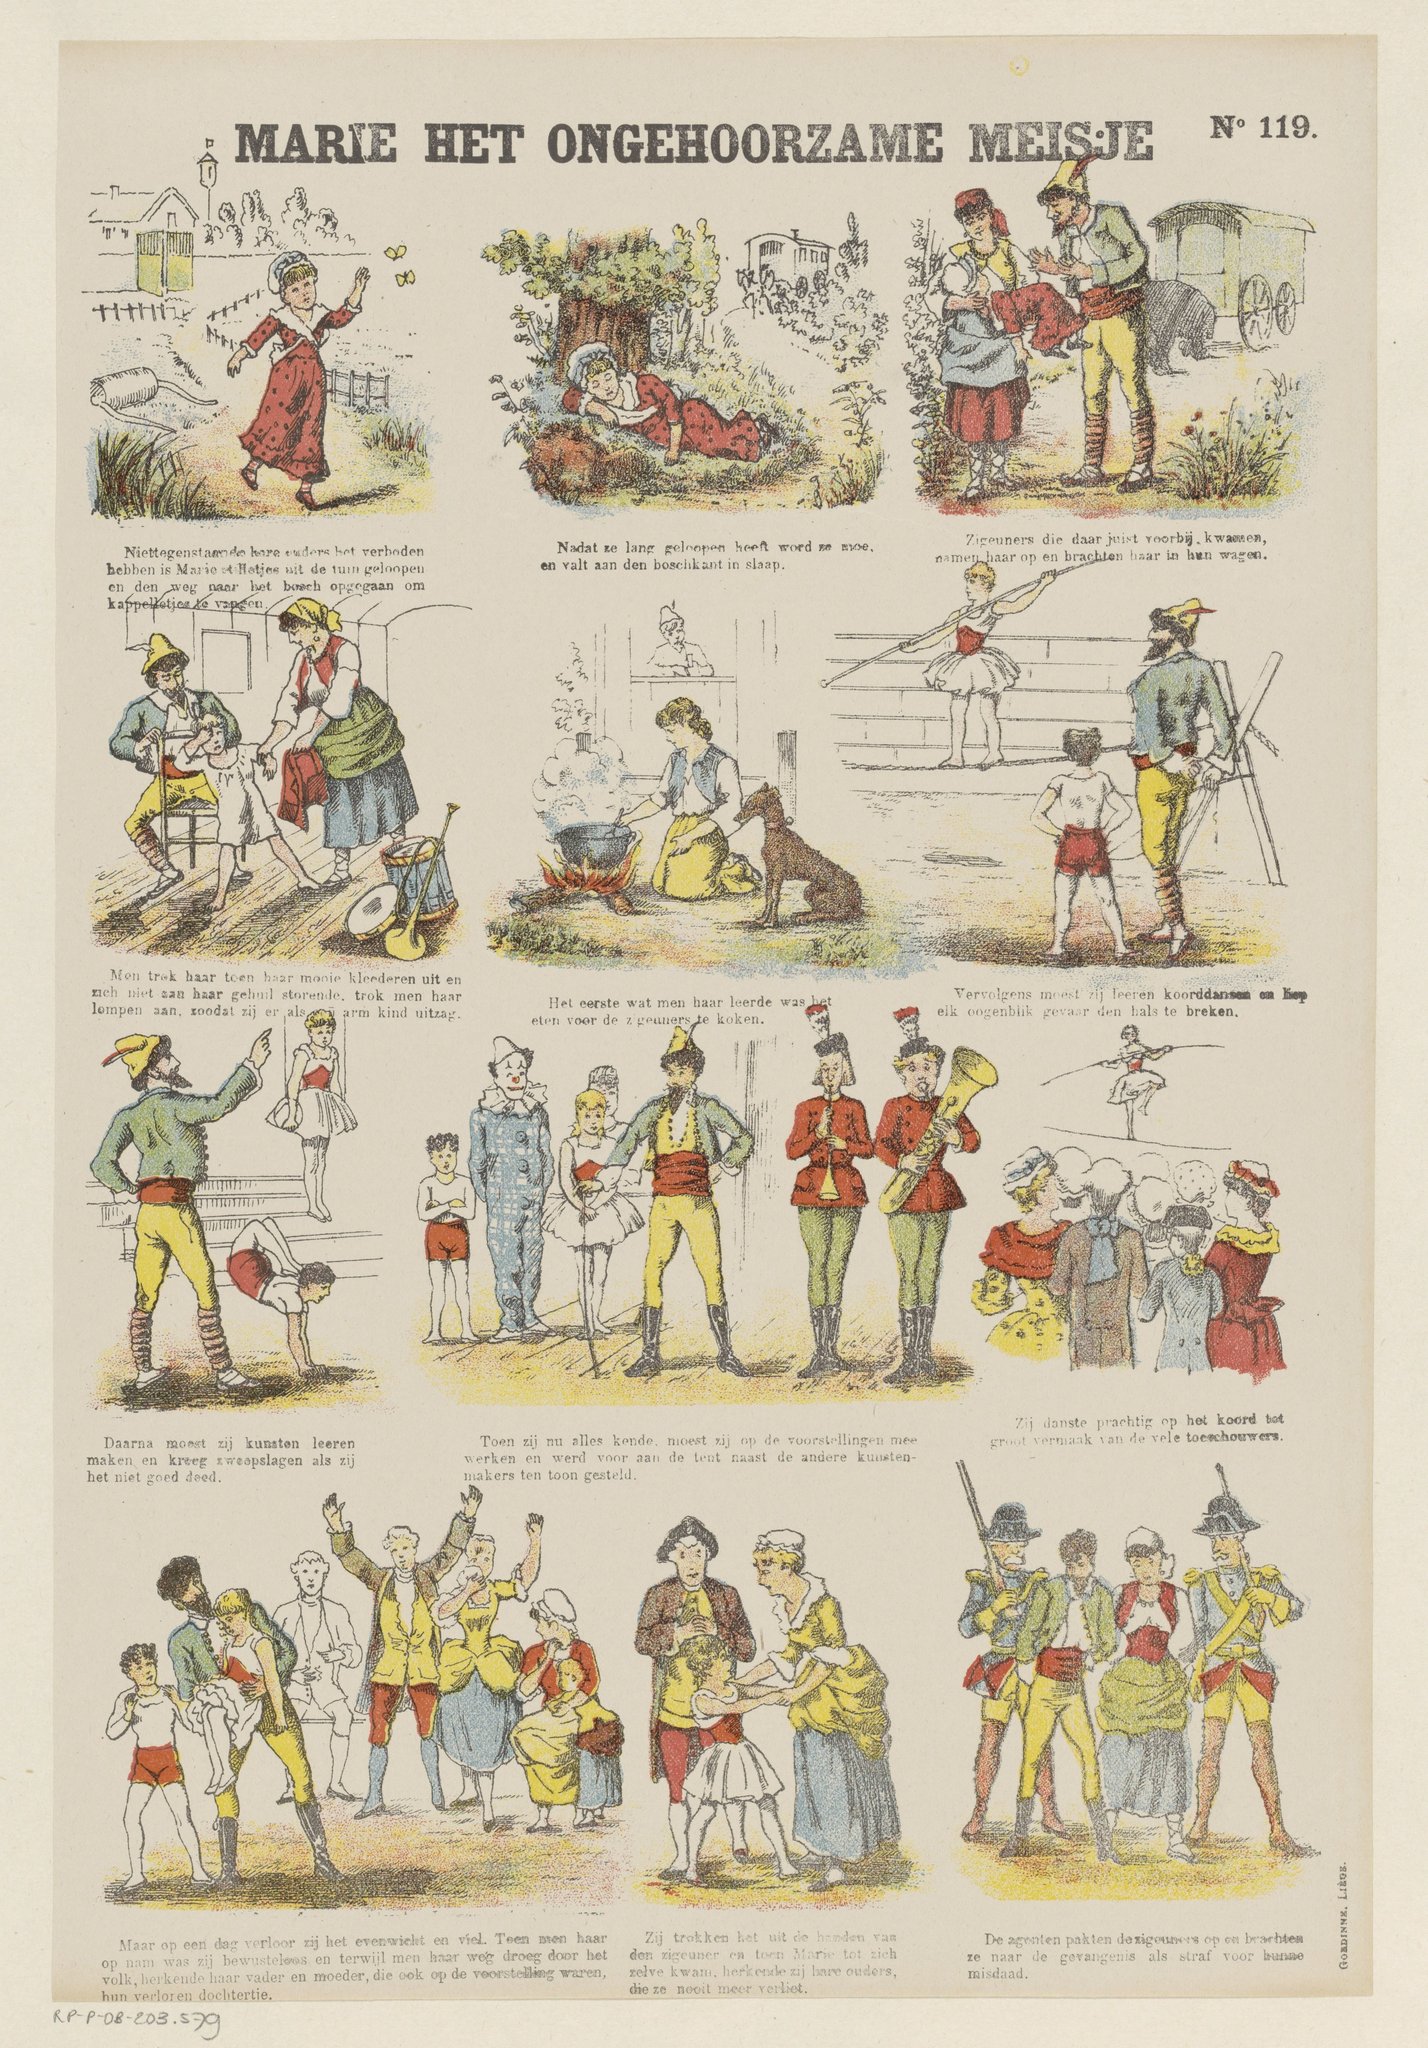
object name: print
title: Marie het ongehoorzame meisje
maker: Anonymous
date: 1894-1959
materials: paper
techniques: lithograph, letterpress printing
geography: liège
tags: wandering communities: romani or roma, circus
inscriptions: collector's mark: Lugt 2760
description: Blad met 12 voorstellingen over het meisje Marie dat verdwaalt in het woud. Zij wordt gevonden door Roma of Sinti en gedwongen in het circus te werken. Een man herkent Marie en brengt haar terug naar haar ouders. Onder elke afbeelding een onderschrift. Genummerd rechtsboven: No 119.